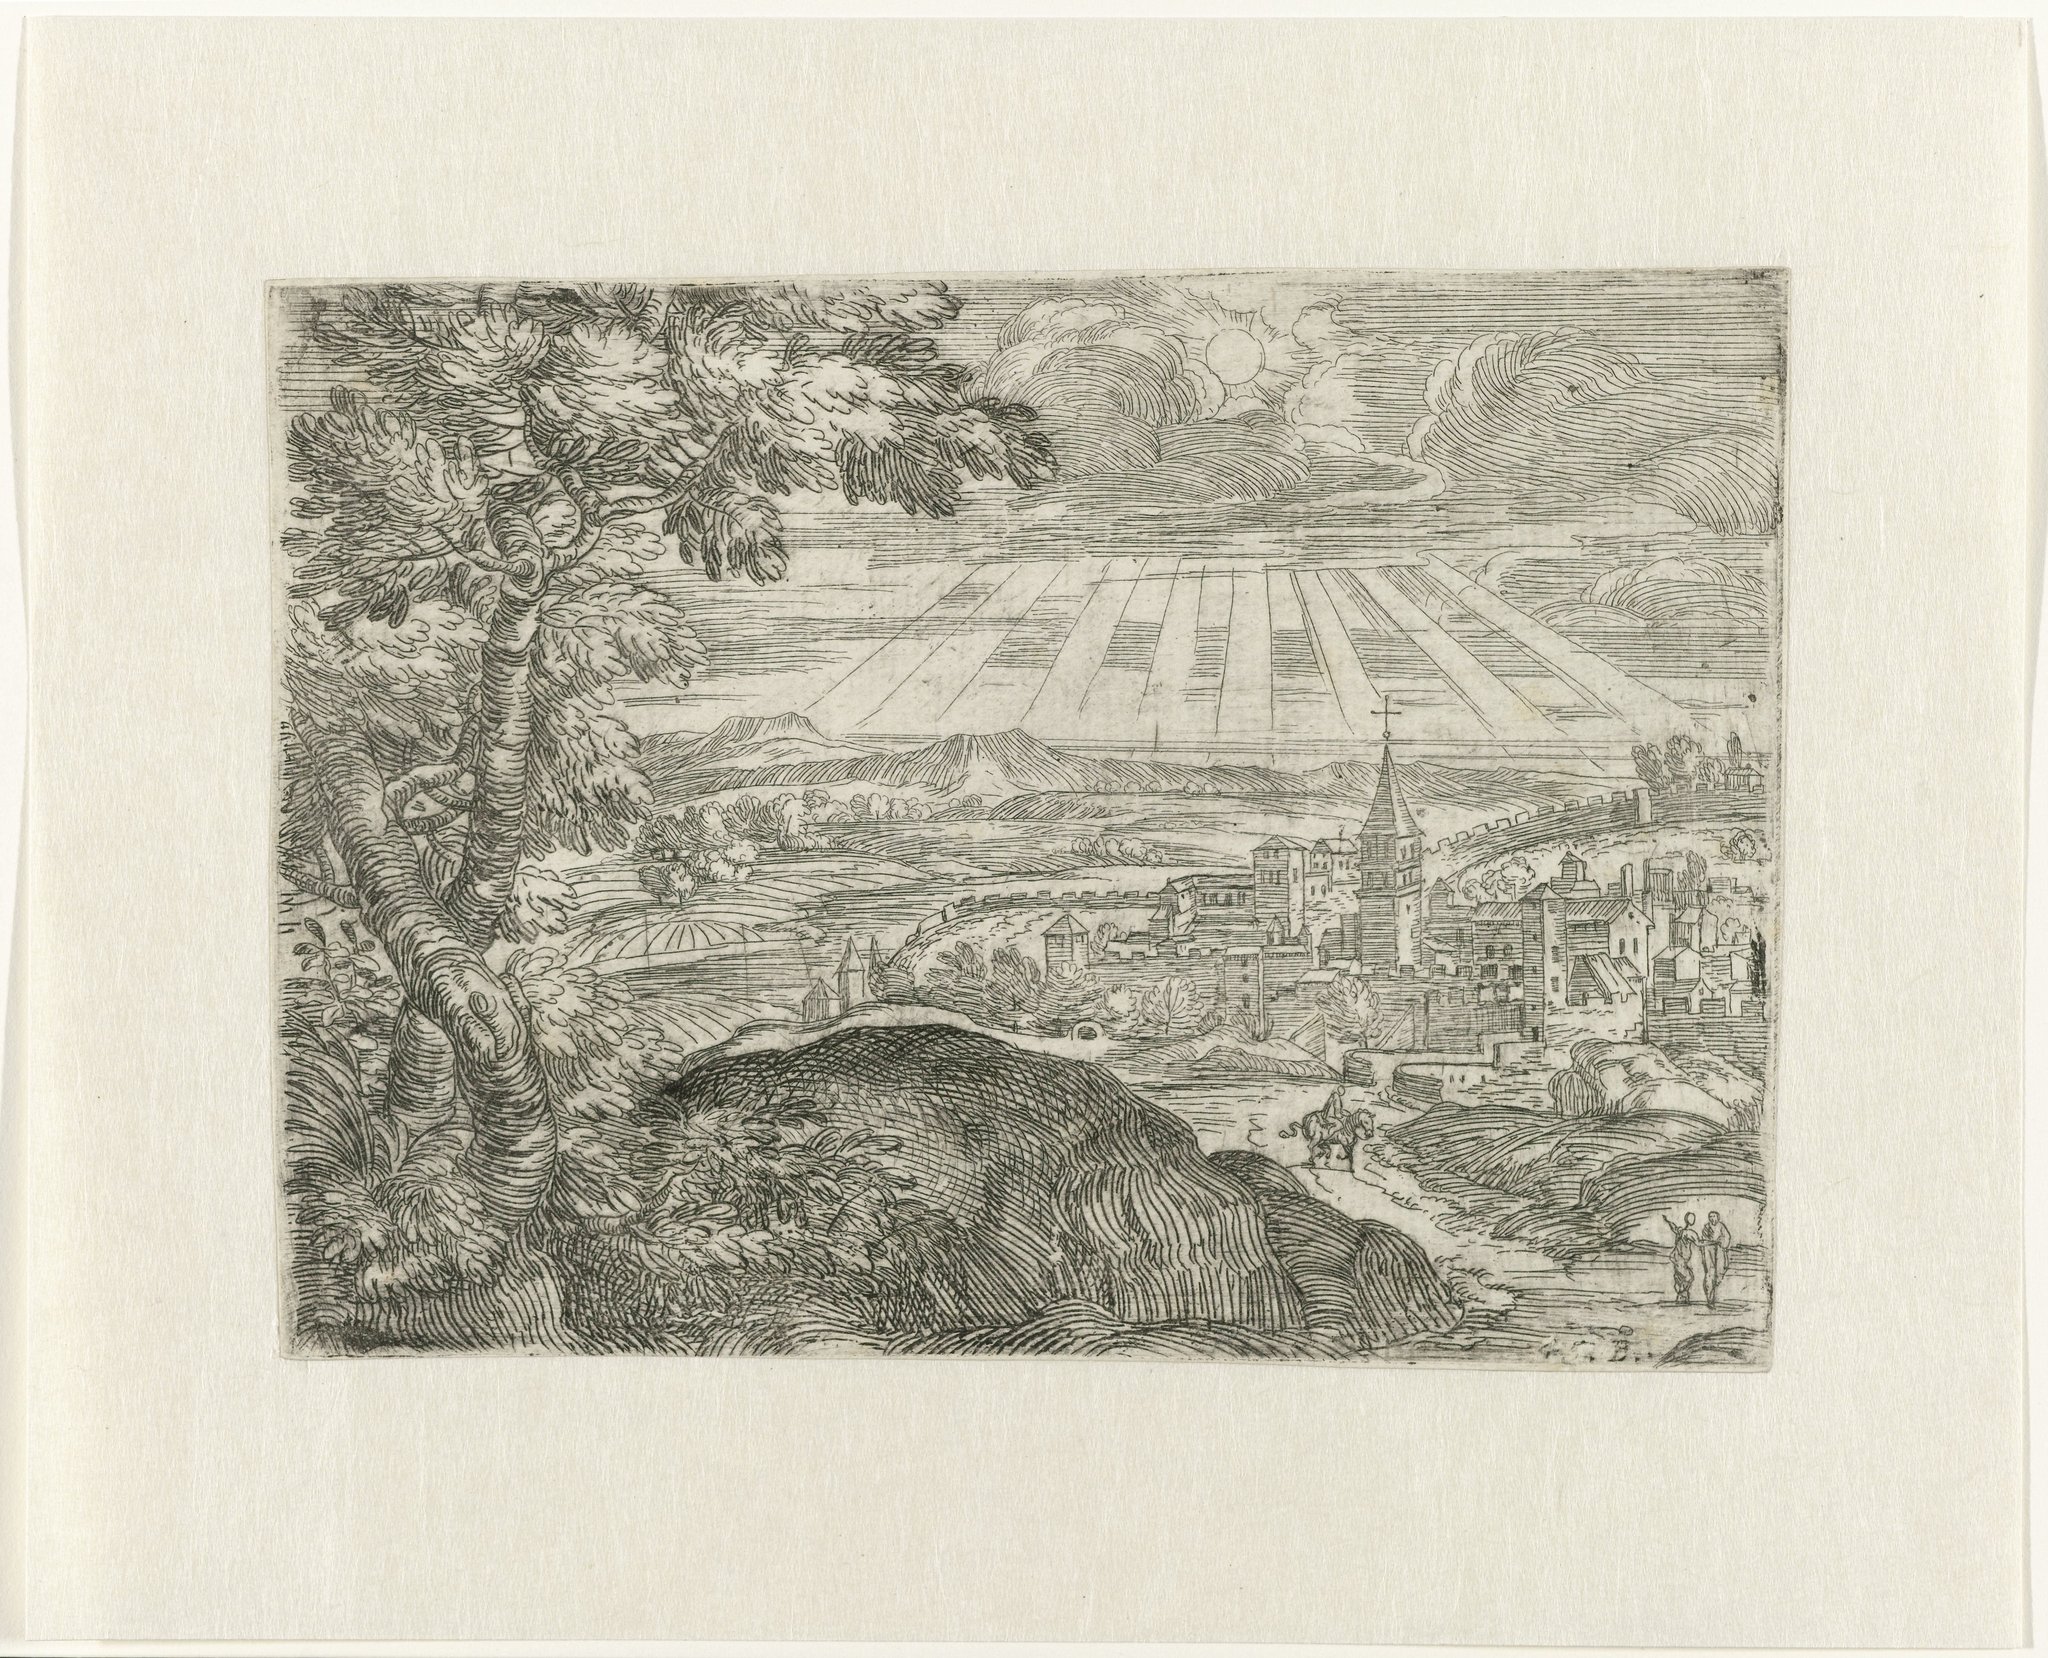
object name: print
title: Landschap met stadszicht en stralende zon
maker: Anonymous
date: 1550-1570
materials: paper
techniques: etching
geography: italy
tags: city-view, and landscape with man-made constructions, landscapes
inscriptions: collector's mark: Lugt 2228, collector's mark: Lugt 2760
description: Landschap met bomenpartij links en uitgestrekt landschap met zicht op een ommuurde Italiaanse stad met prominente kerktoren. Het geheel baadt in het zonlicht dat door de wolken heen straalt. Een ruiter bevindt zich op de landweg die naar de stad leidt.